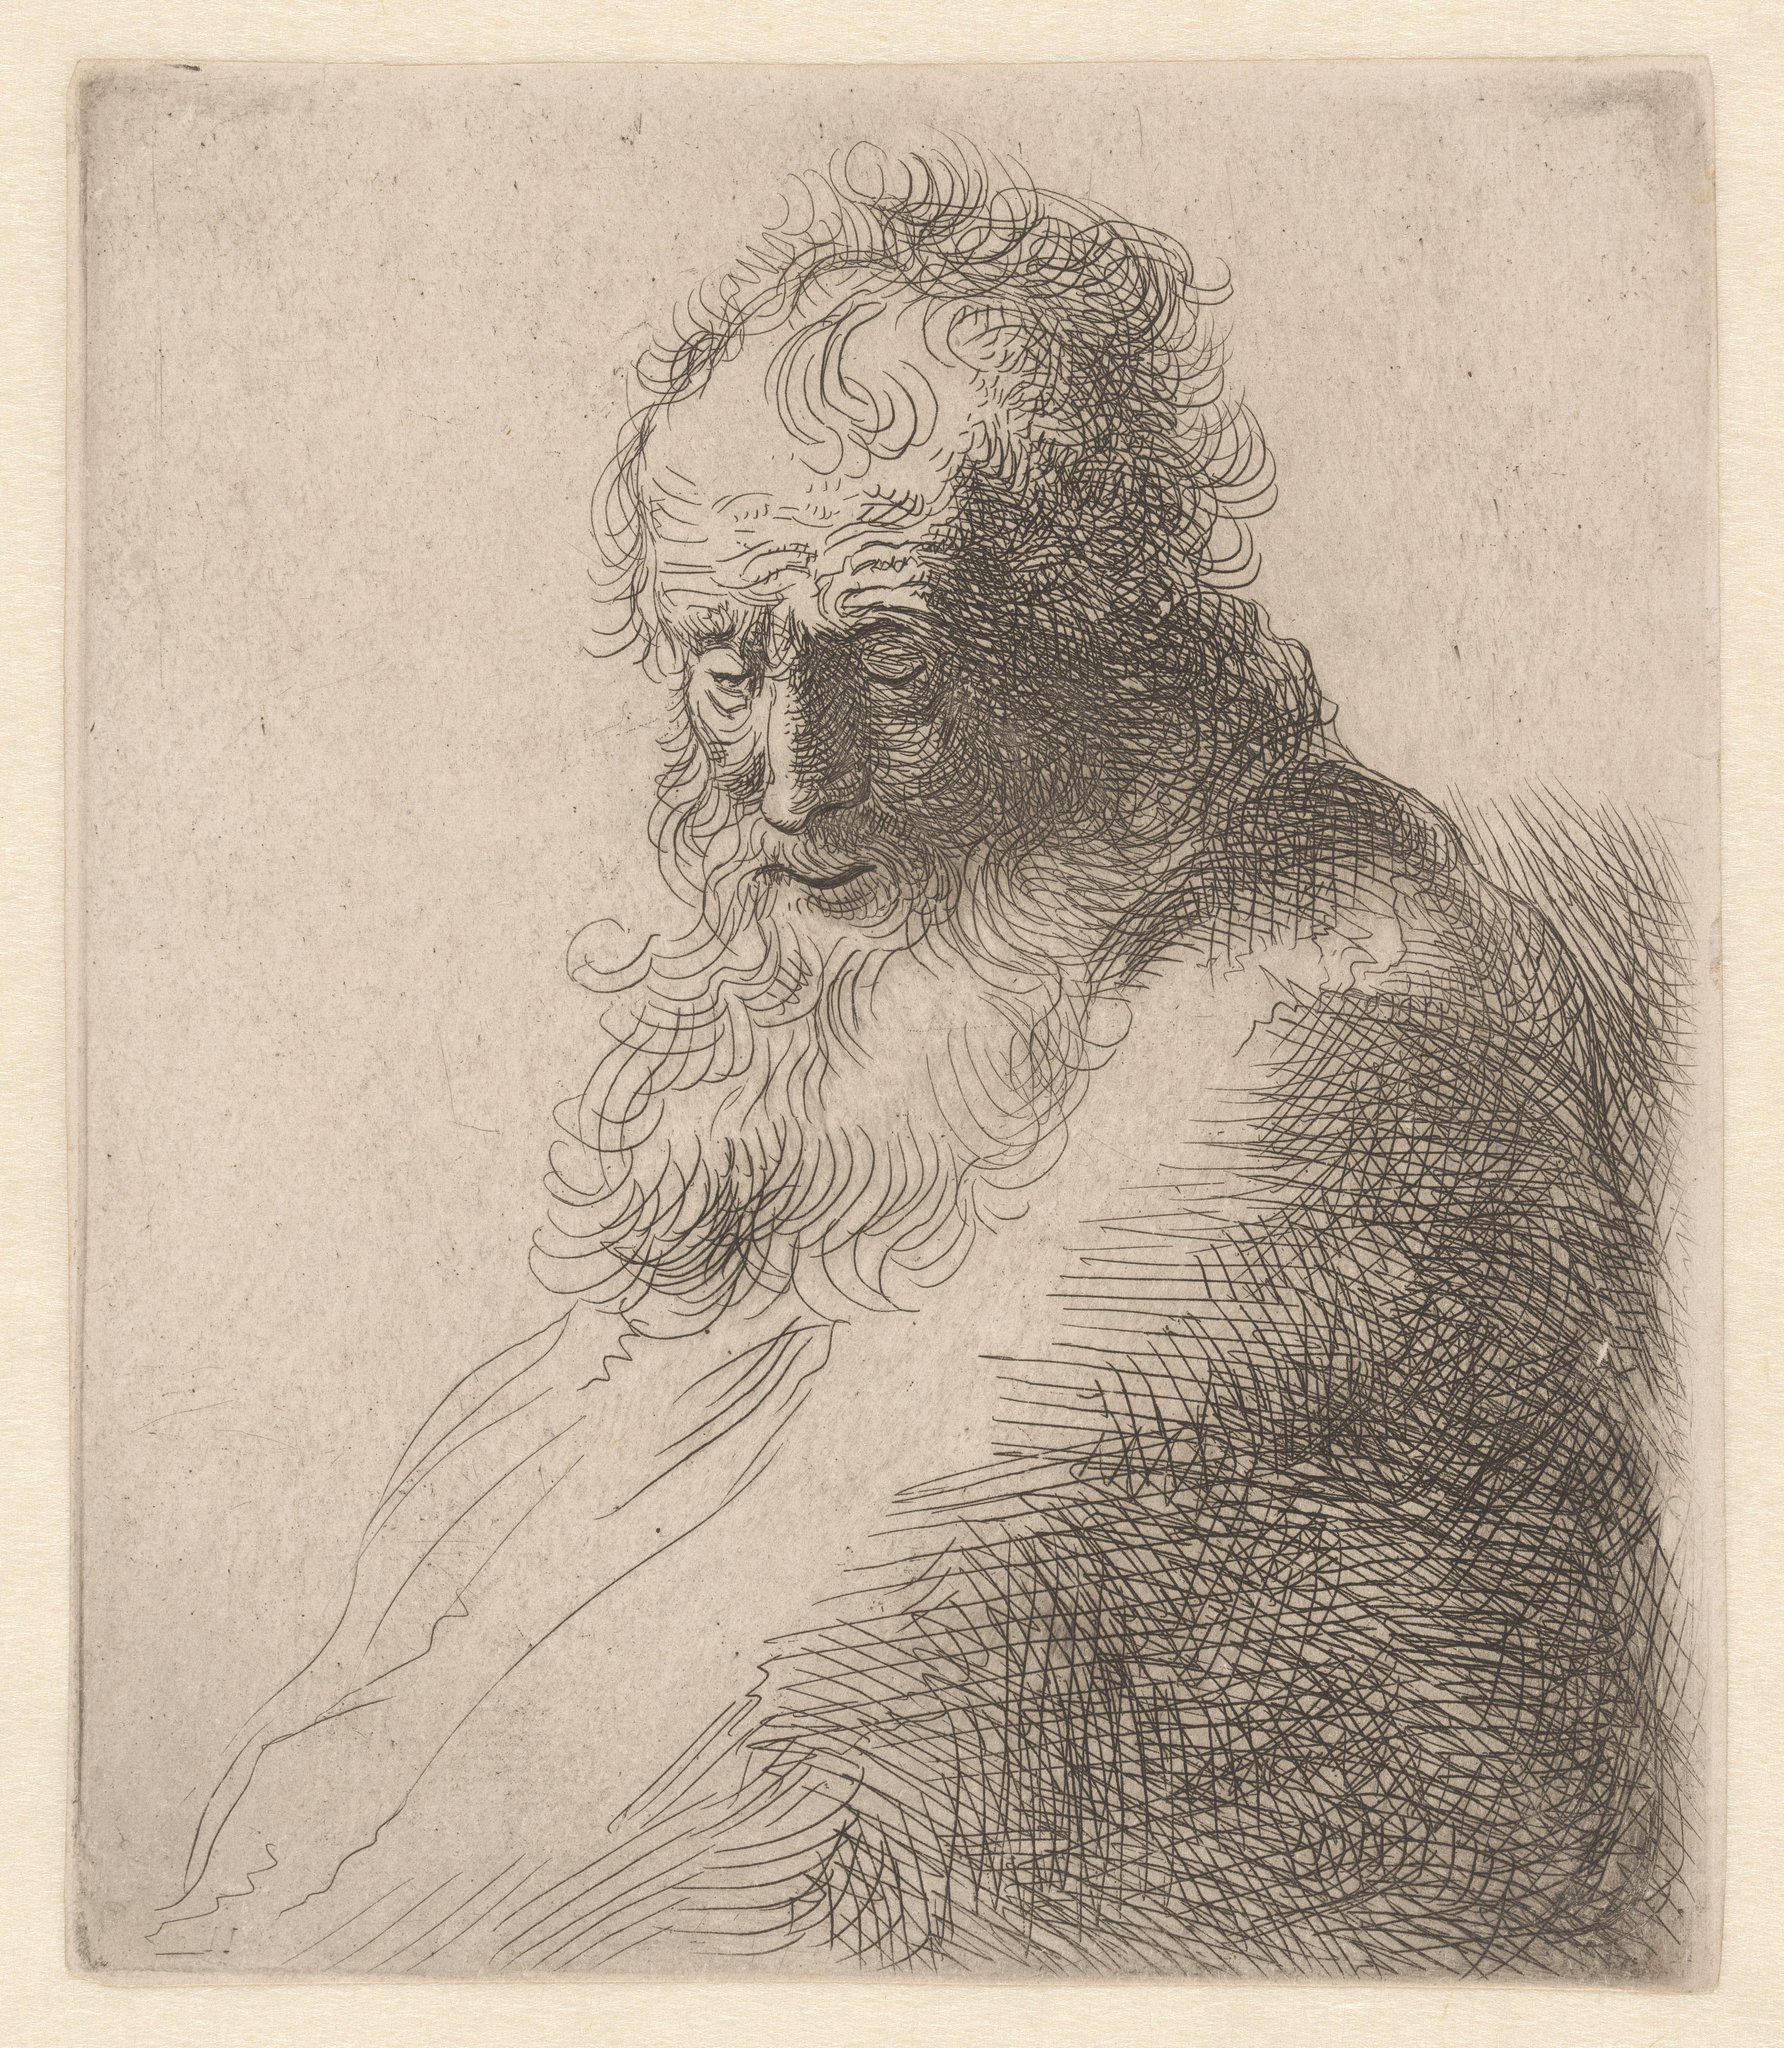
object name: print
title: Bust of an old bearded man, looking down, three quarters right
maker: michael willmann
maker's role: draughtsman, print maker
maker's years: 1630-1706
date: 1640-1706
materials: paper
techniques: etching, intaglio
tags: old man, beard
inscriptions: collector's mark: Lugt 2228, collector's mark: Lugt 2760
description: Spiegelbeeldige kopie naar de gelijknamige prent van Rembrandt.